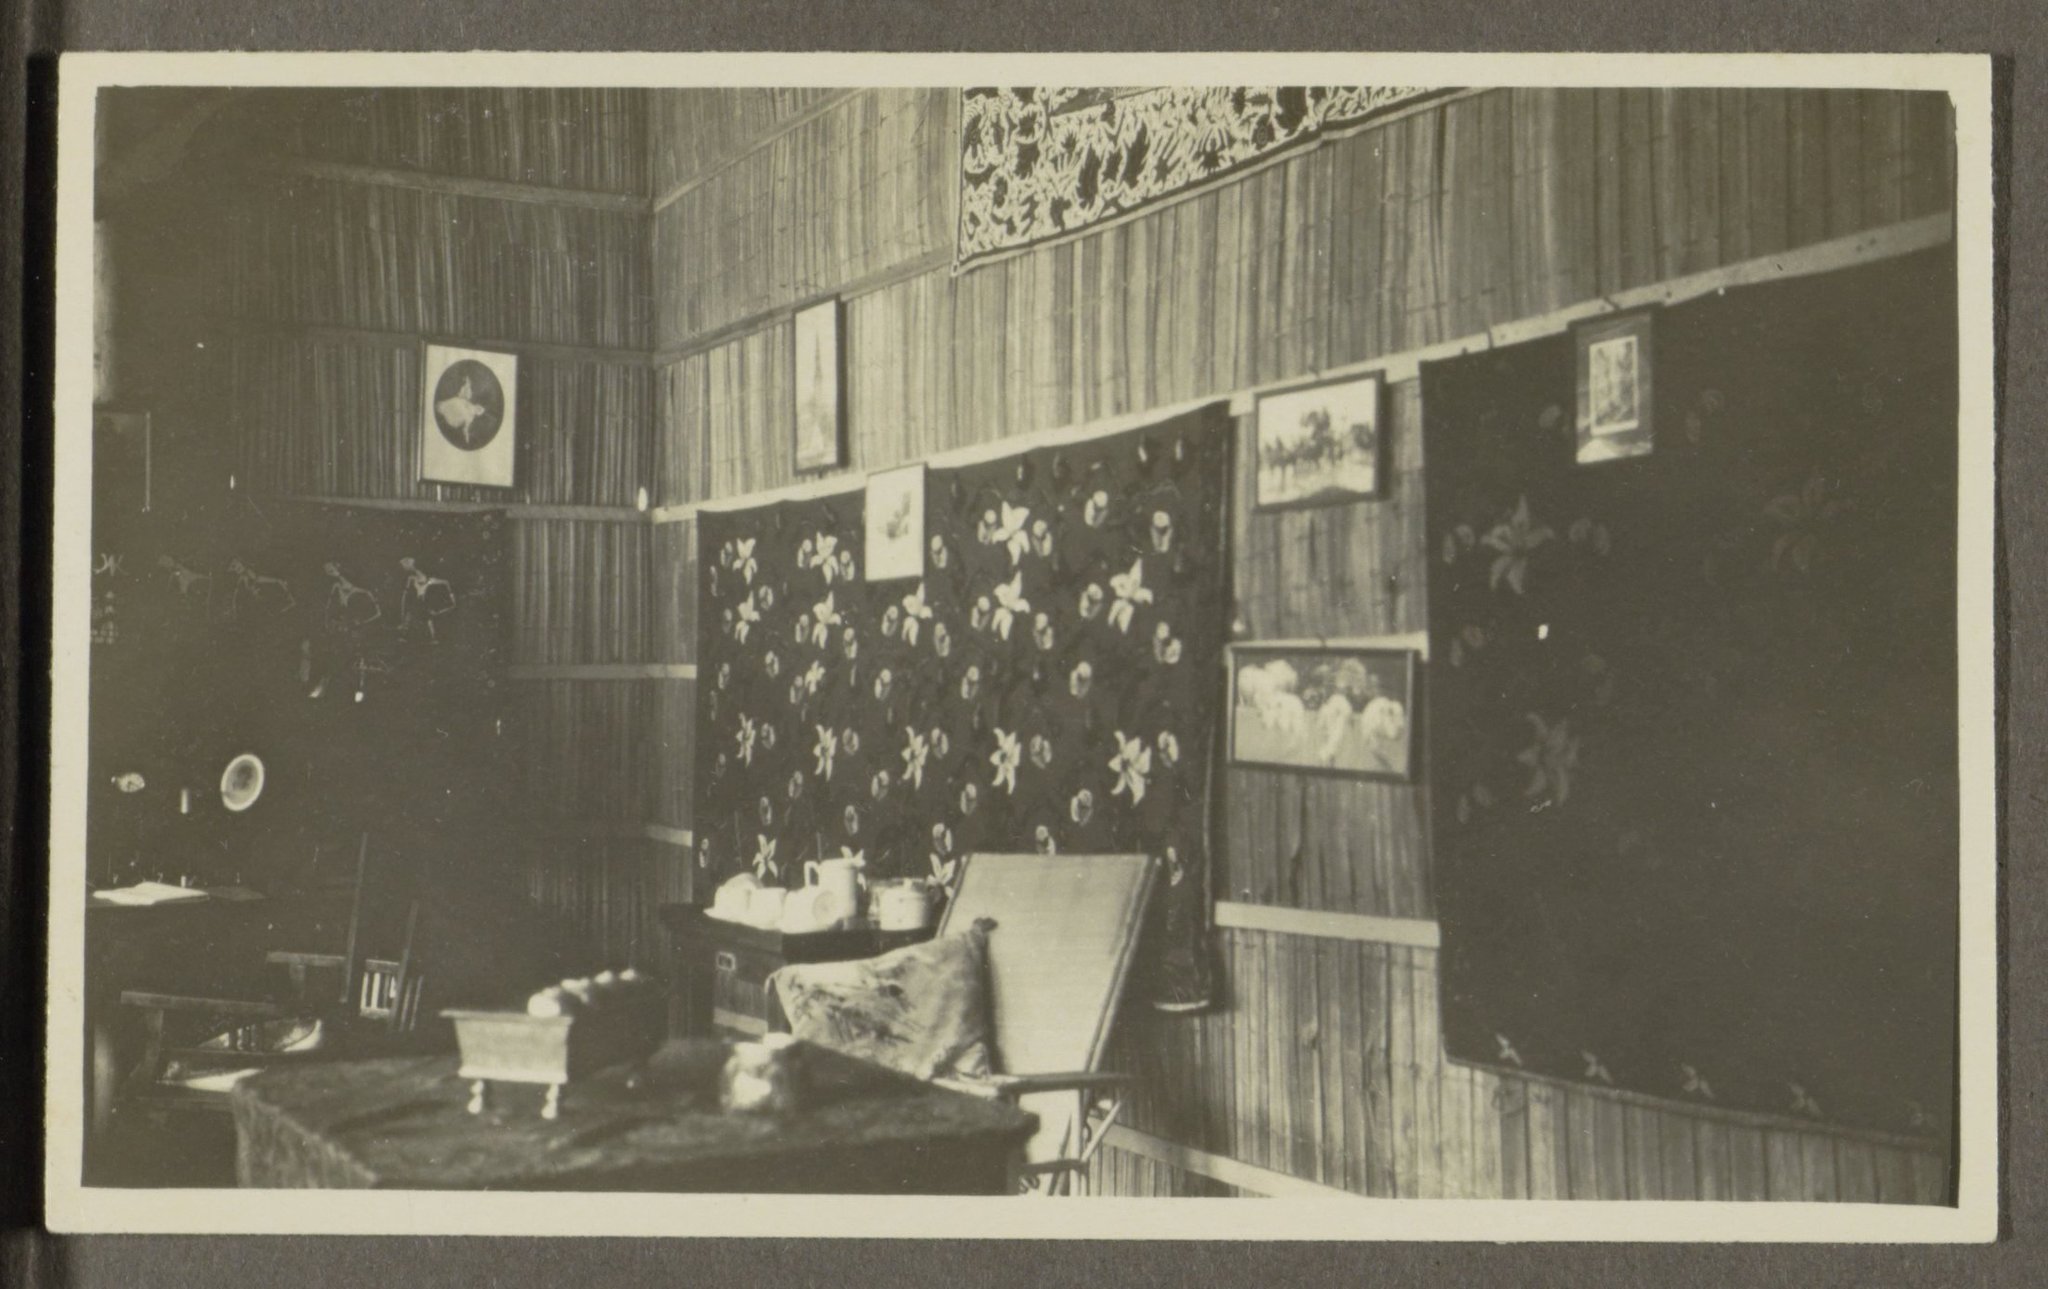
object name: photograph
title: Hoek van een kamer met gebatikte kleden en ingelijste afbeeldingen aan de muren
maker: Anonymous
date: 1920-1930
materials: photographic support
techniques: gelatin silver print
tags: dyeing of cloth with pattern; batik-work, interior of the house, dutch east indies, the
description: Onderdeel van familiealbum Nederlands-Indië.